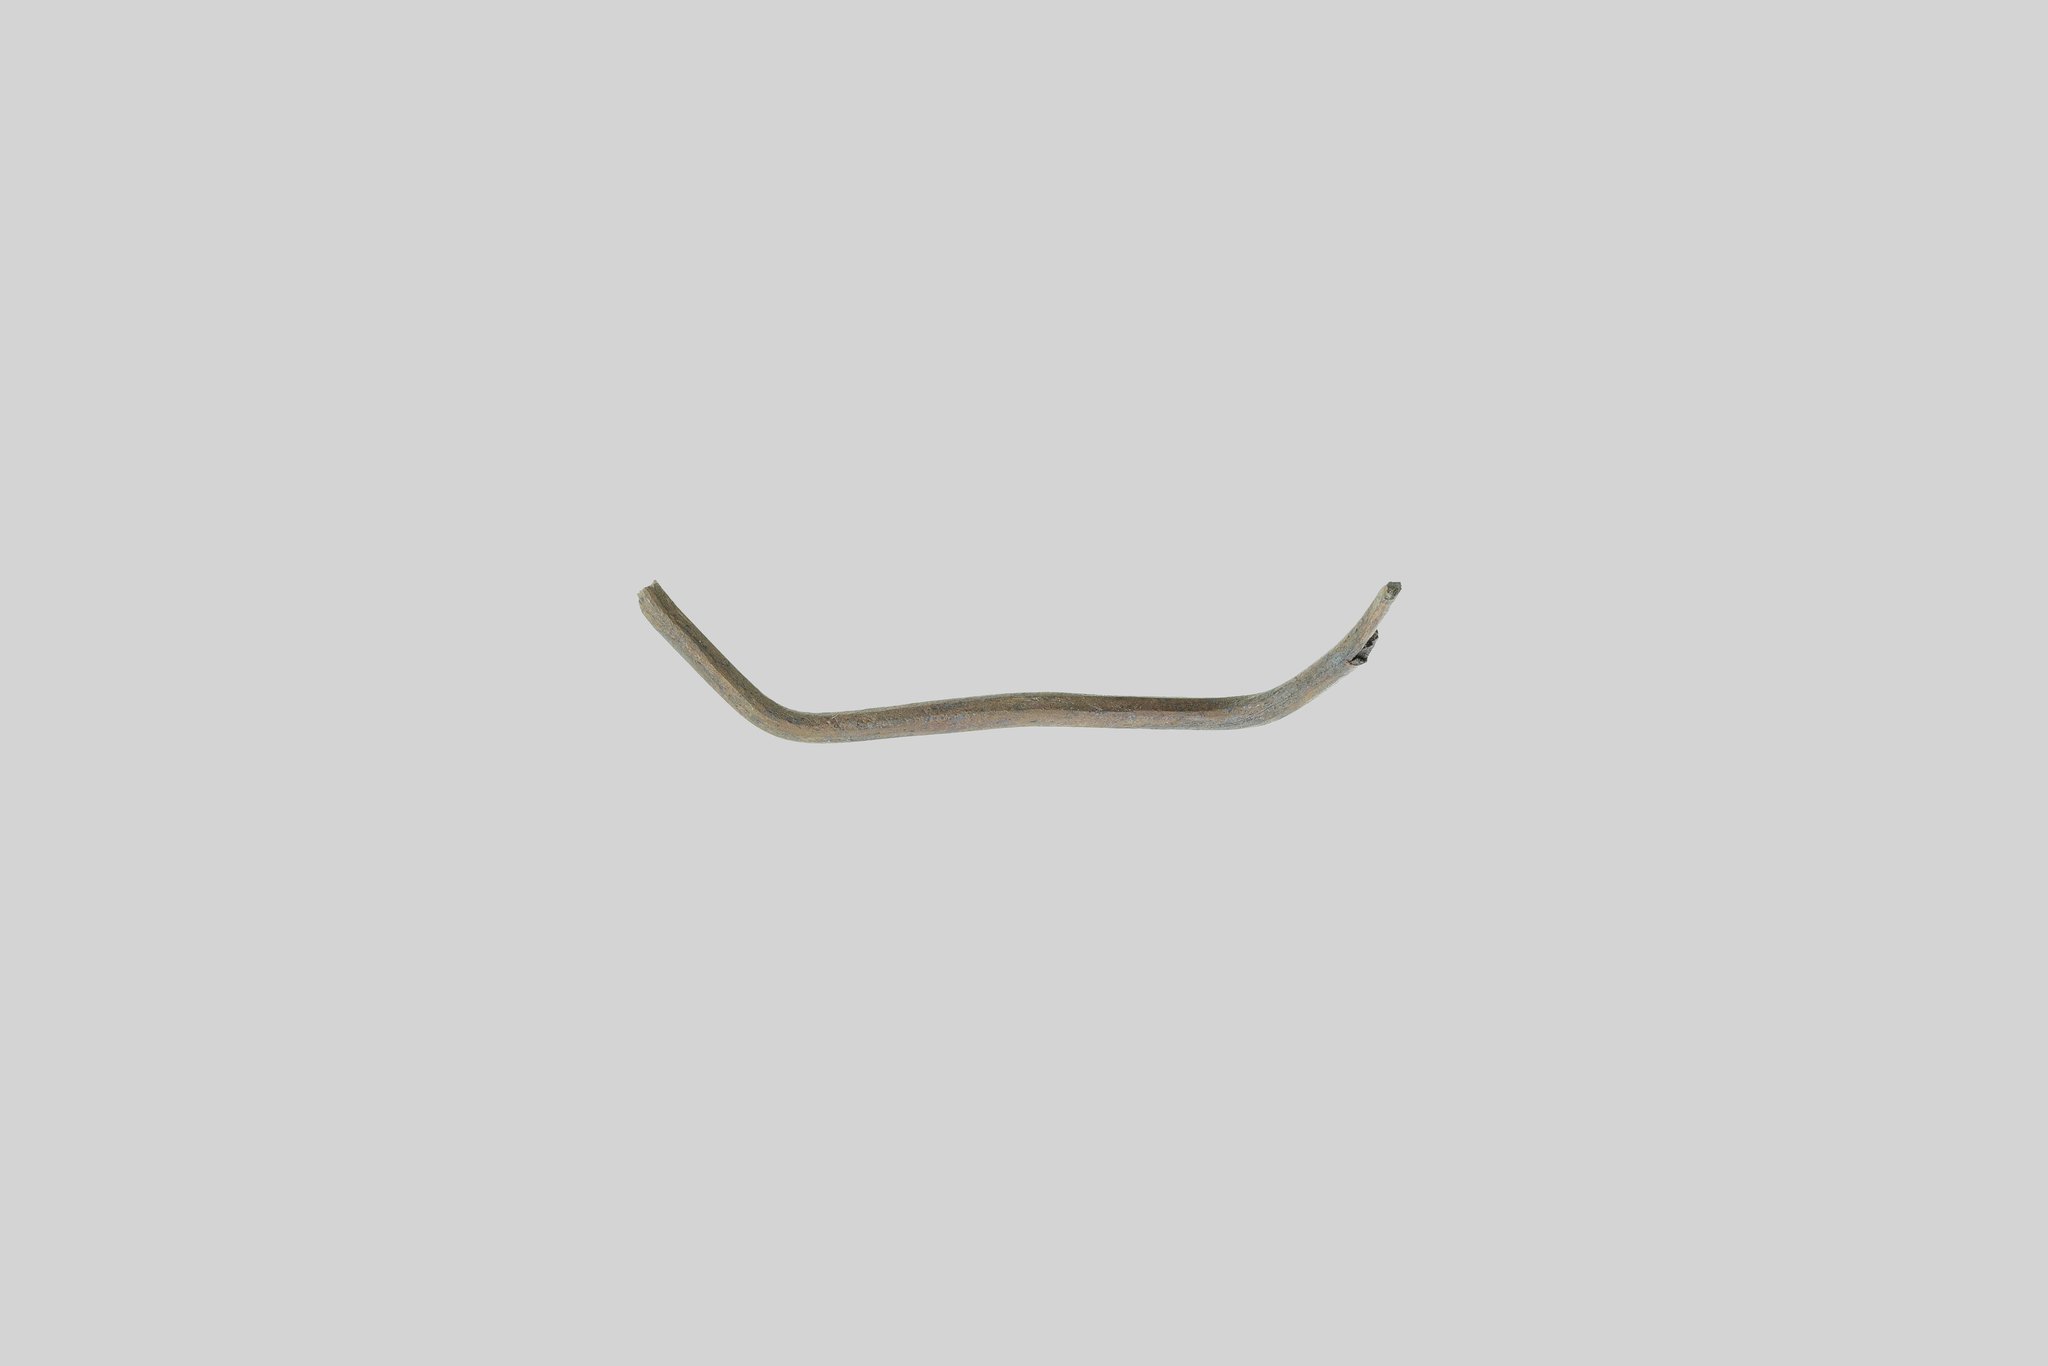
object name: rod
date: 664-332 BCE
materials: copper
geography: egypt